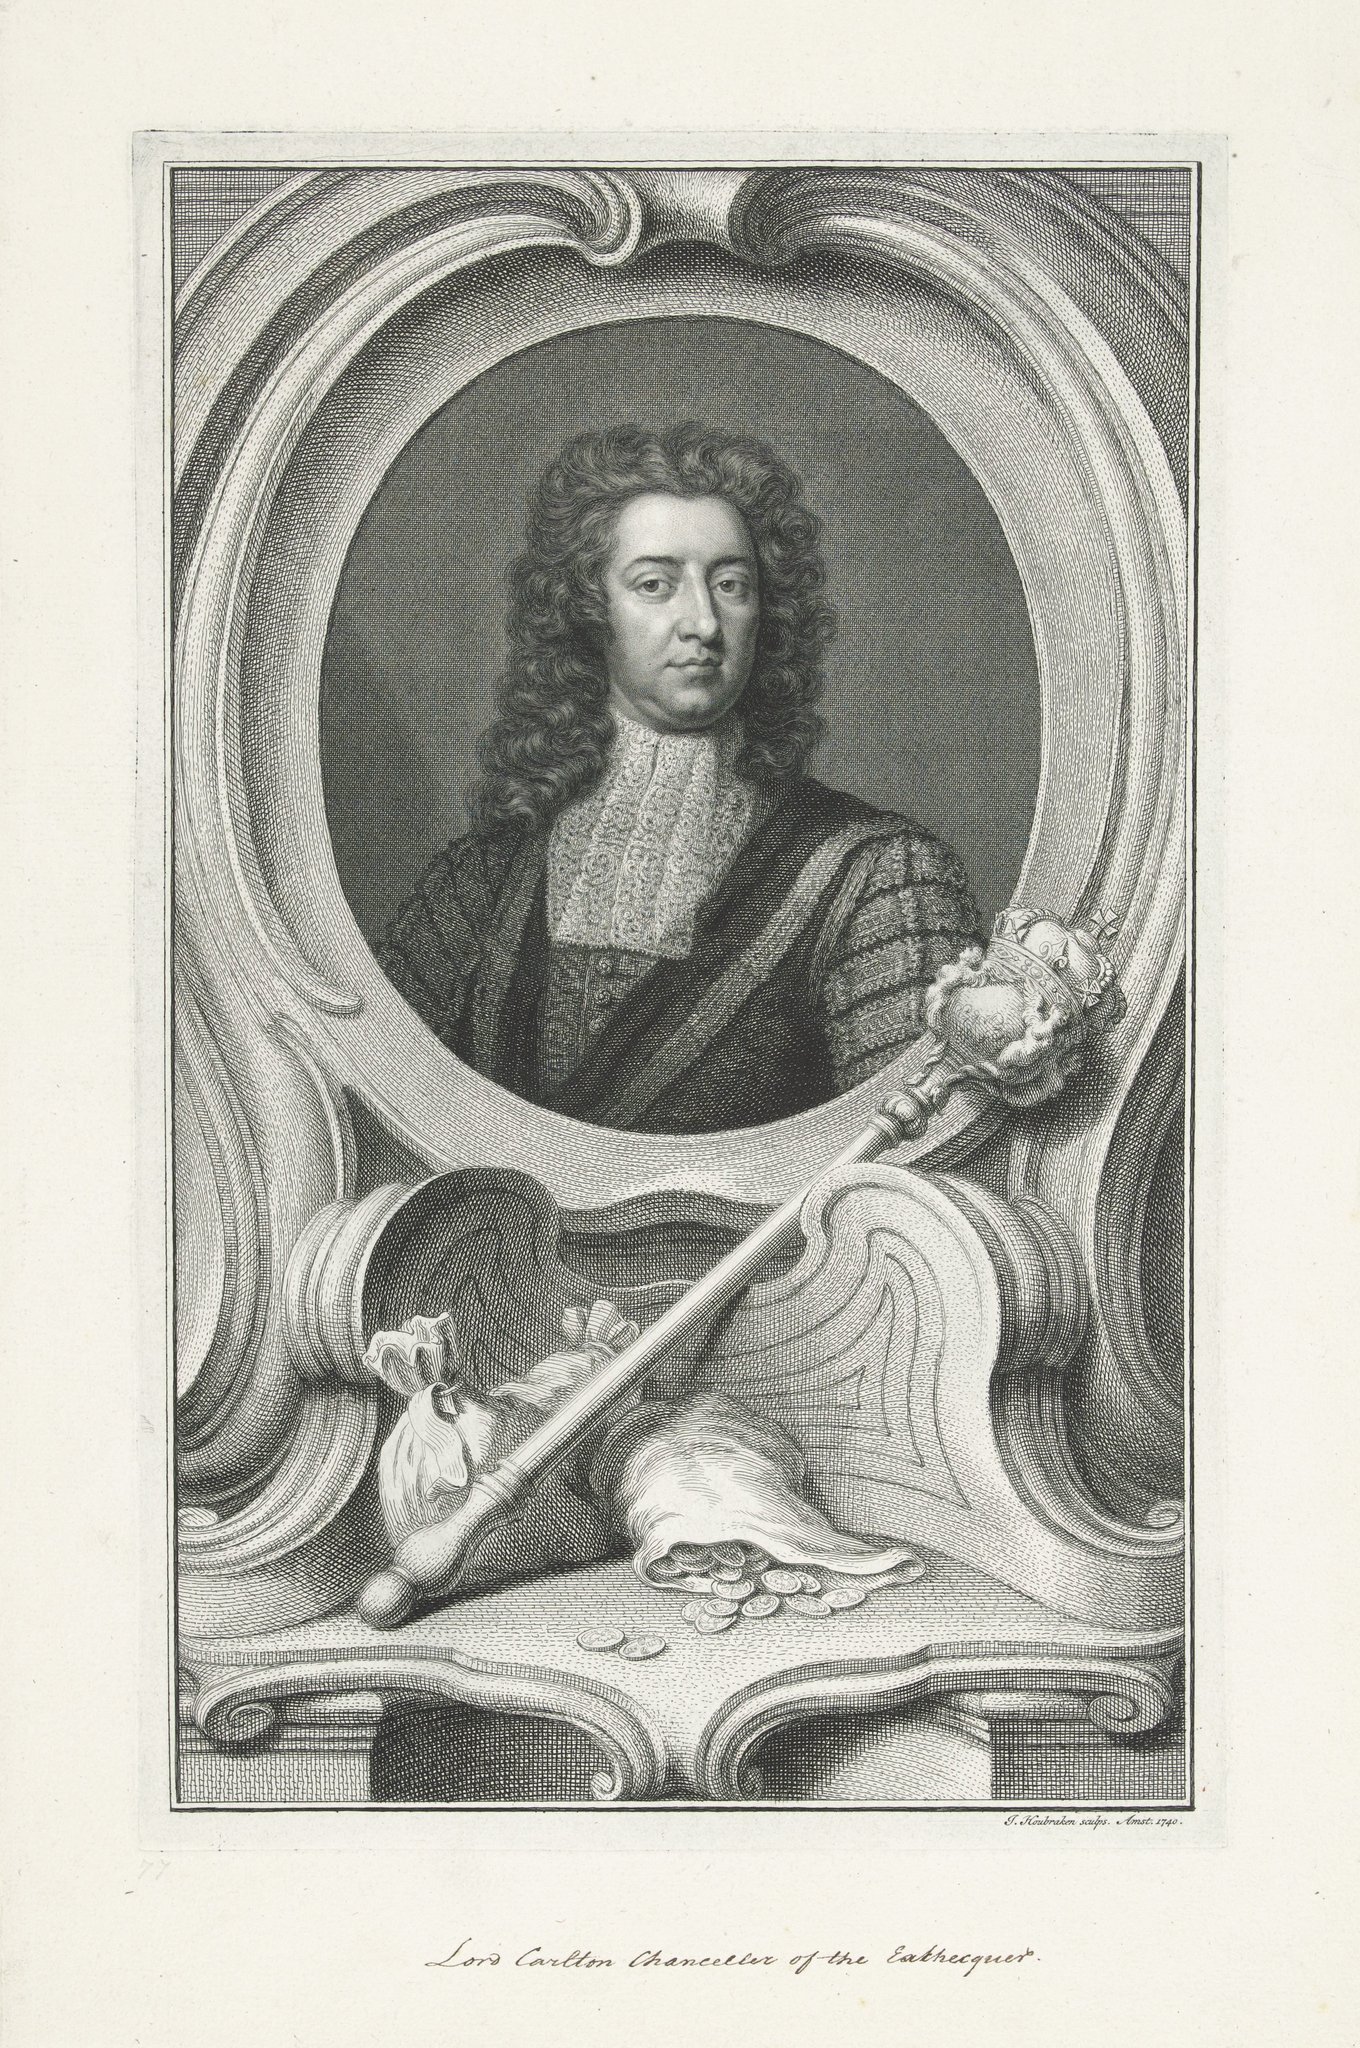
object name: print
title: Portret van Henry Boyle, 1e baron Carleton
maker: jacob houbraken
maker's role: draughtsman, print maker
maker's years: 1698-1780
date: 1740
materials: paper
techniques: engraving, etching, pen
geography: amsterdam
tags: politician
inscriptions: collector's mark: Lugt 240, name: ‘Lored Carlton Chanceller of the Eathecquer’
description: Prent ook gebruikt in: Thomas Birch. The heads of illustrious persons of Great Britain : engraved by Houbraken, and Vertue, with their lives and characters. London: John en Paul Knapton, 1743-1751.